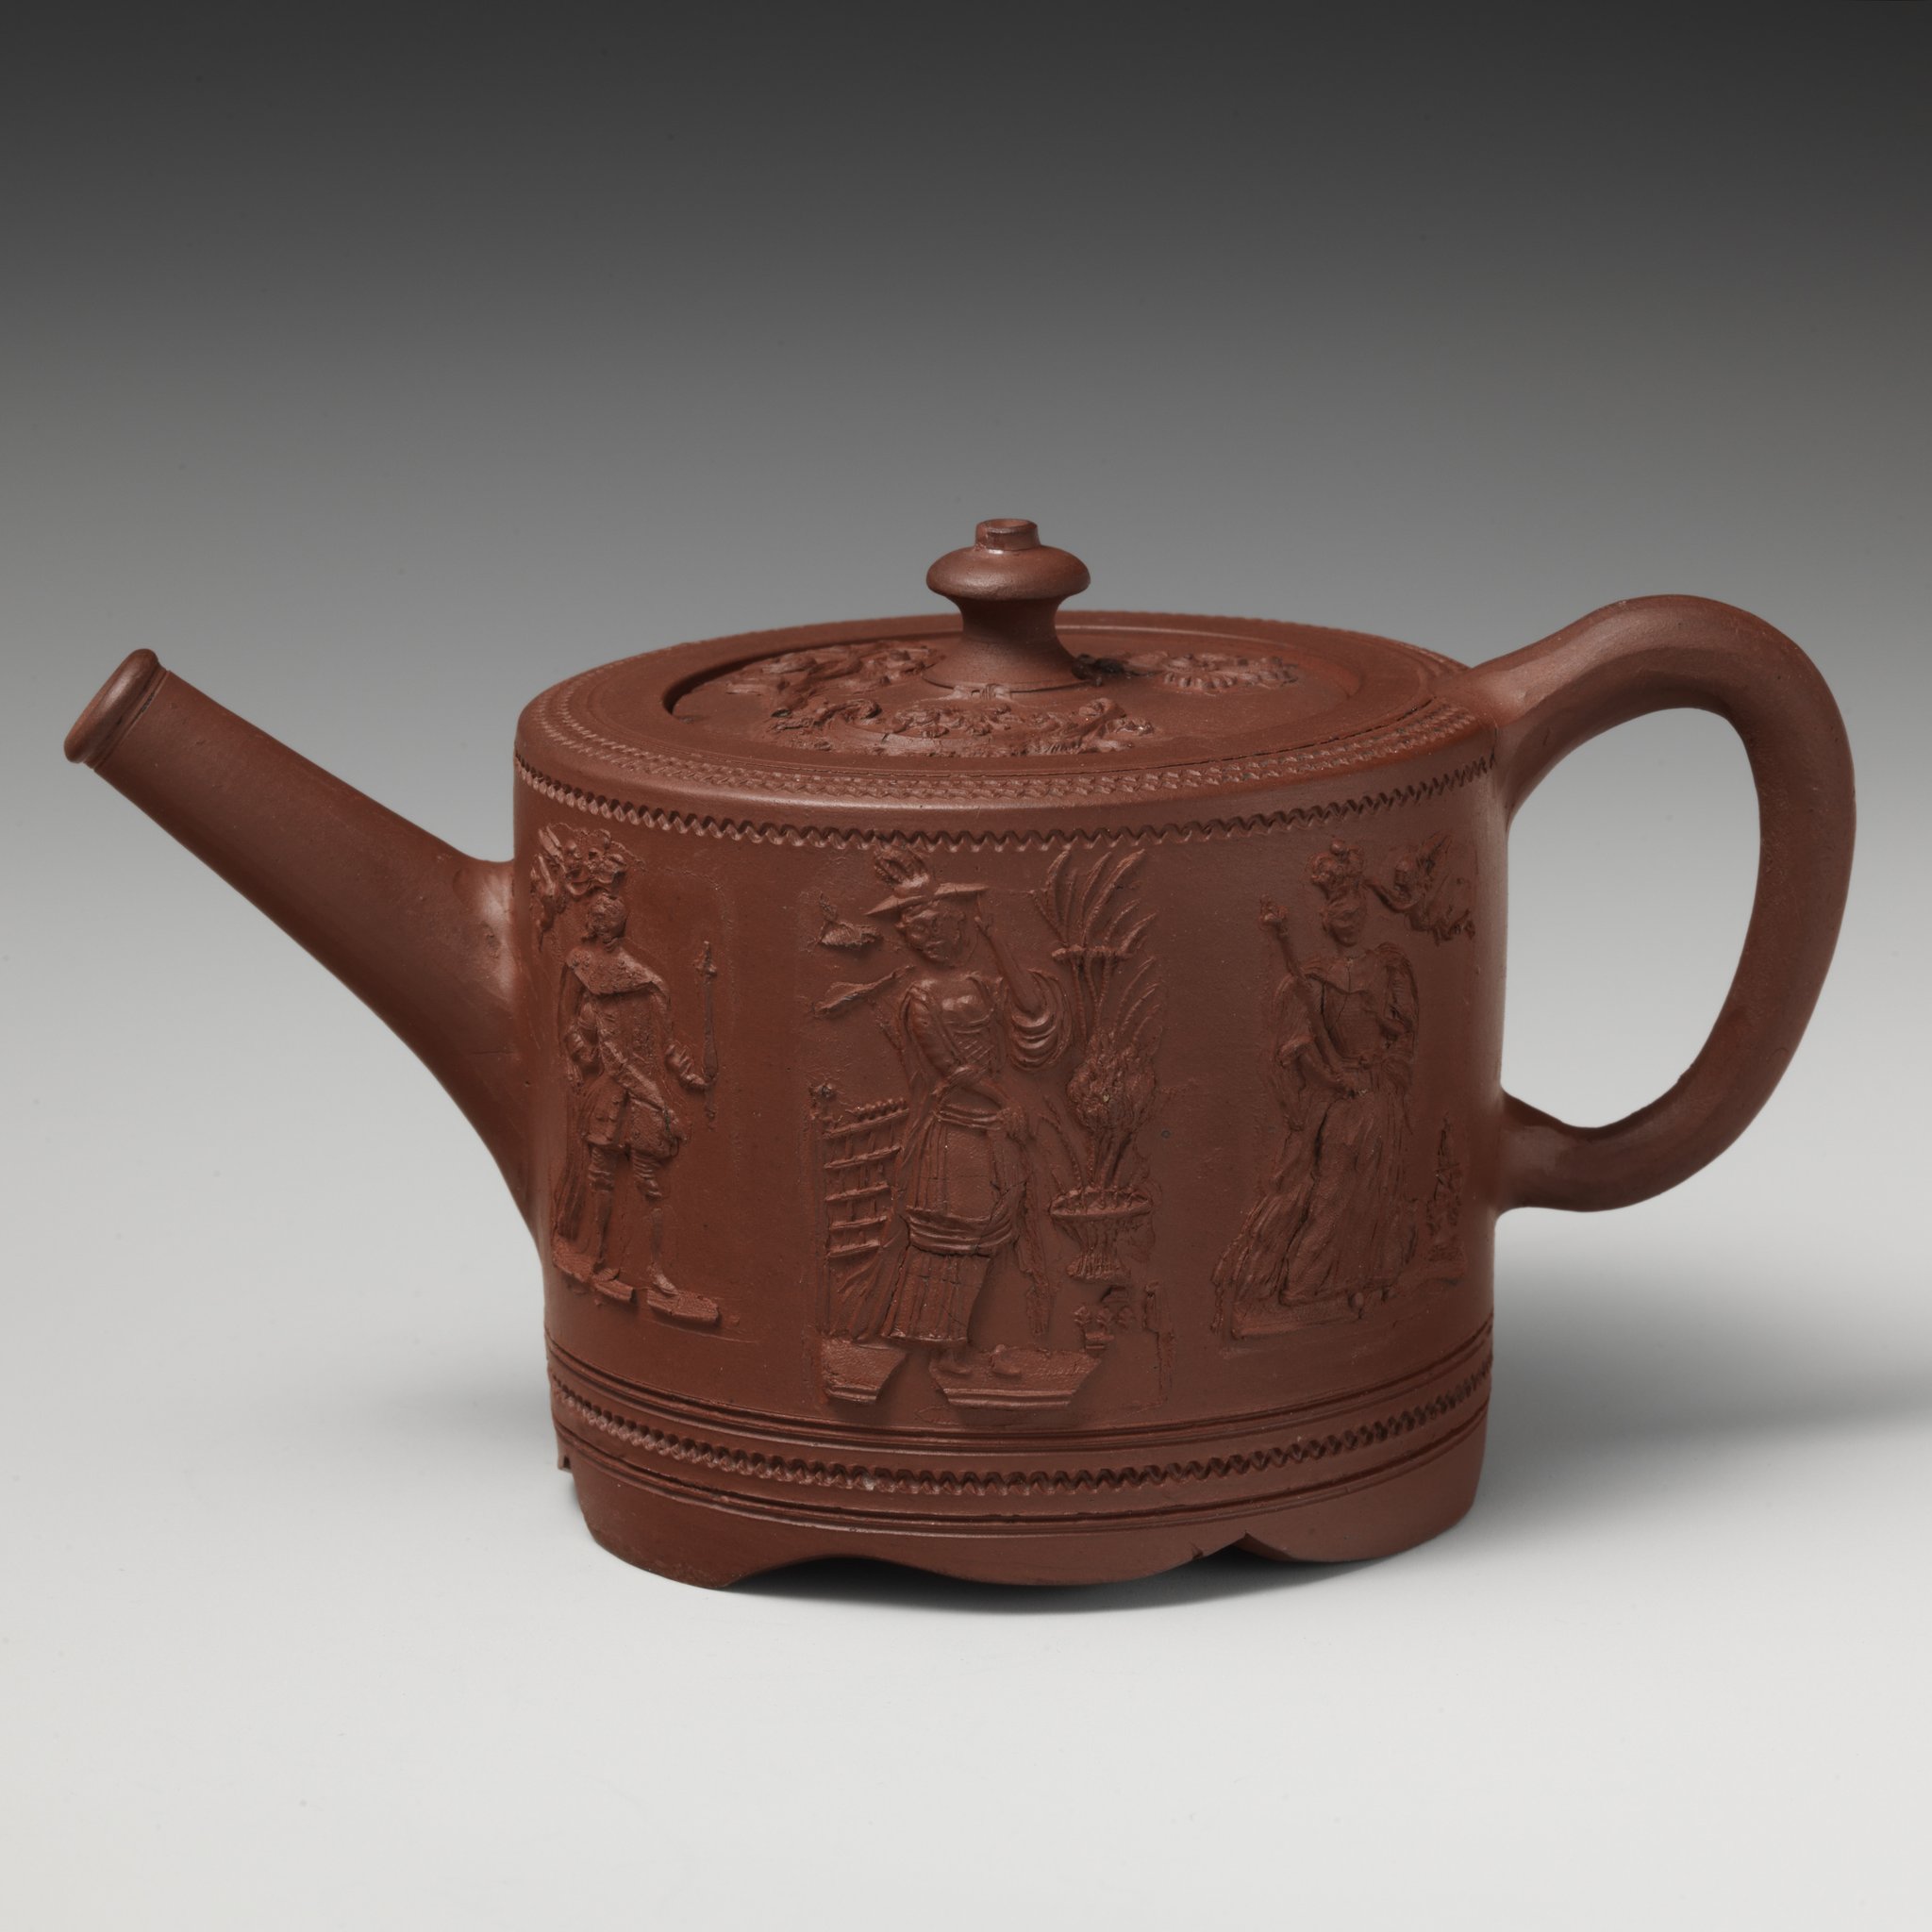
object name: teapot with cover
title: Teapot with King George III (1738–1820) and Queen Charlotte (1744–1818)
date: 1761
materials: stoneware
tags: men,women